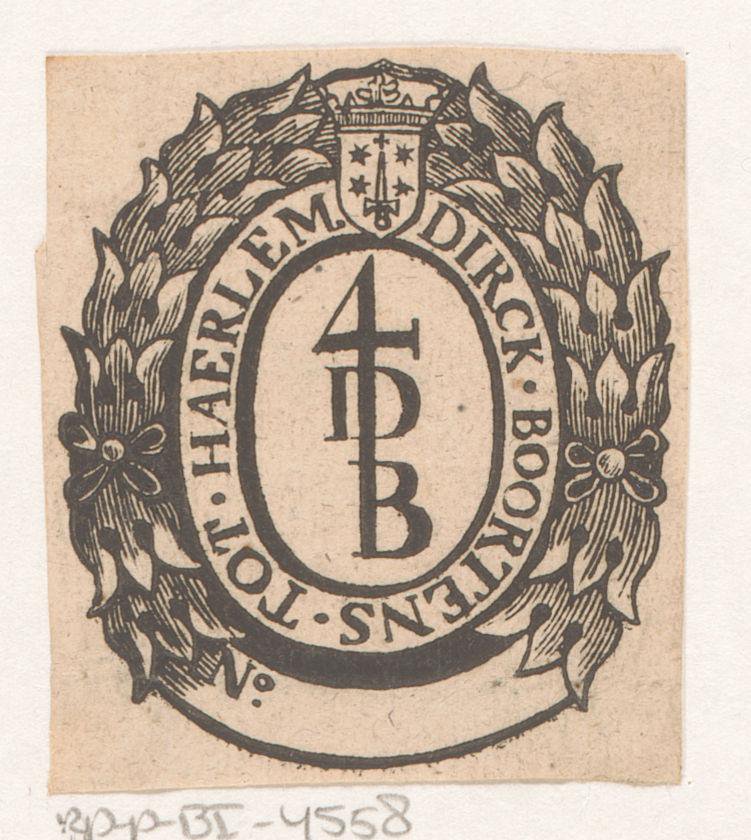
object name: print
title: Vignet van Dirck Boortens te Haarlem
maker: Anonymous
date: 1600-1699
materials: paper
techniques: woodcut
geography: netherlands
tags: coat of arms (as symbol of the state, etc.) (+ city; municipal), vignette, letter combinations such as letterword, anagram, letter square, monogram, etc., haarlem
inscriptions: collector's mark: Lugt 240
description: Het monogram van Dirck Boortens in een ovaal met randschrift. Midden boven het wapen van de stad Haarlem.